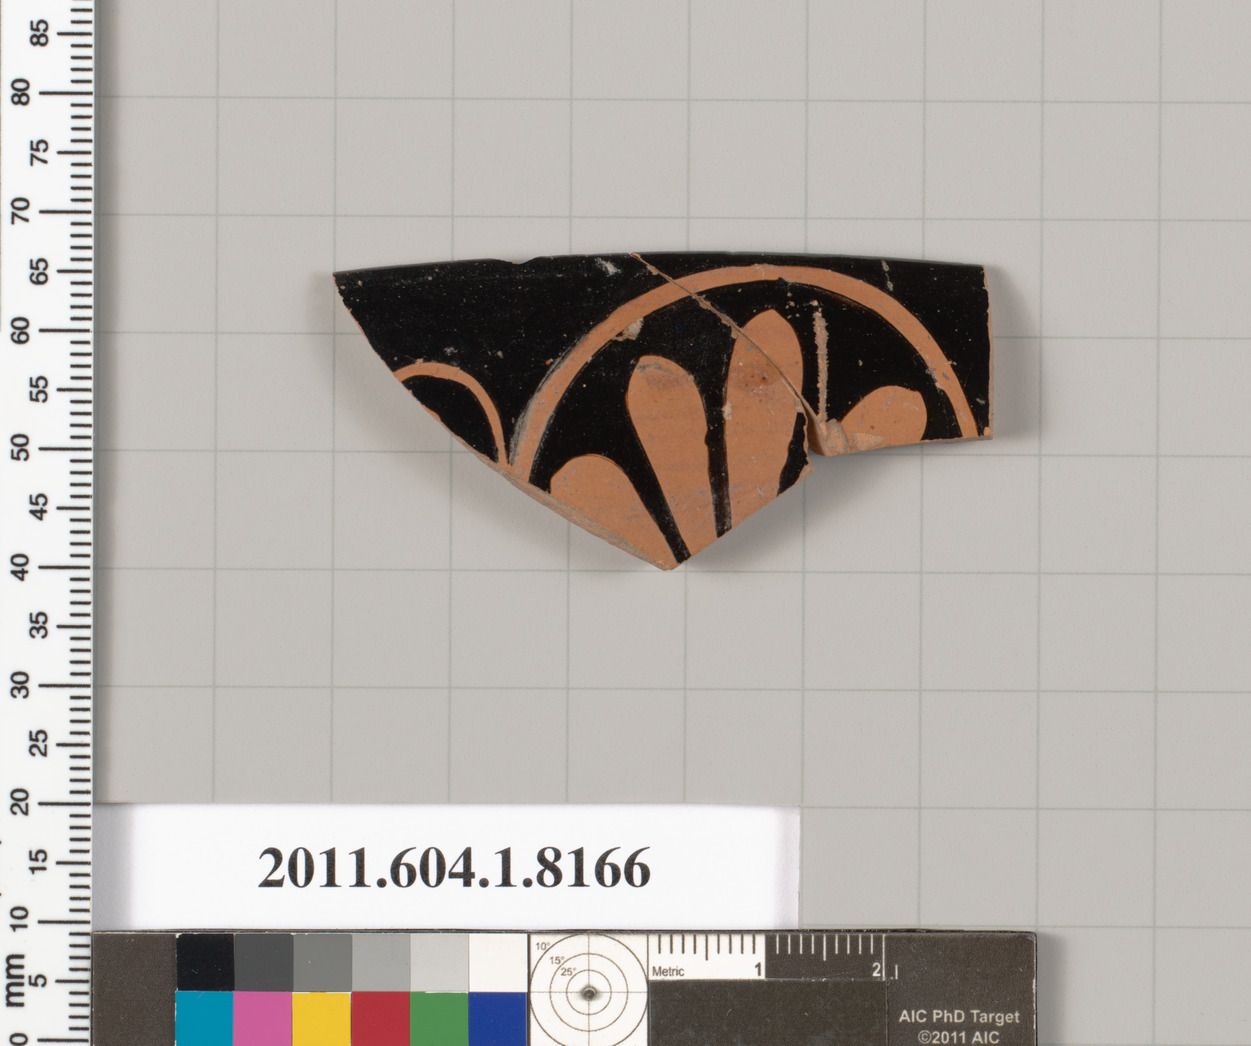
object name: kylix fragment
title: Terracotta rim fragment of a kylix (drinking cup)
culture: greek, attic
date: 520-510 BCE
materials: terracotta